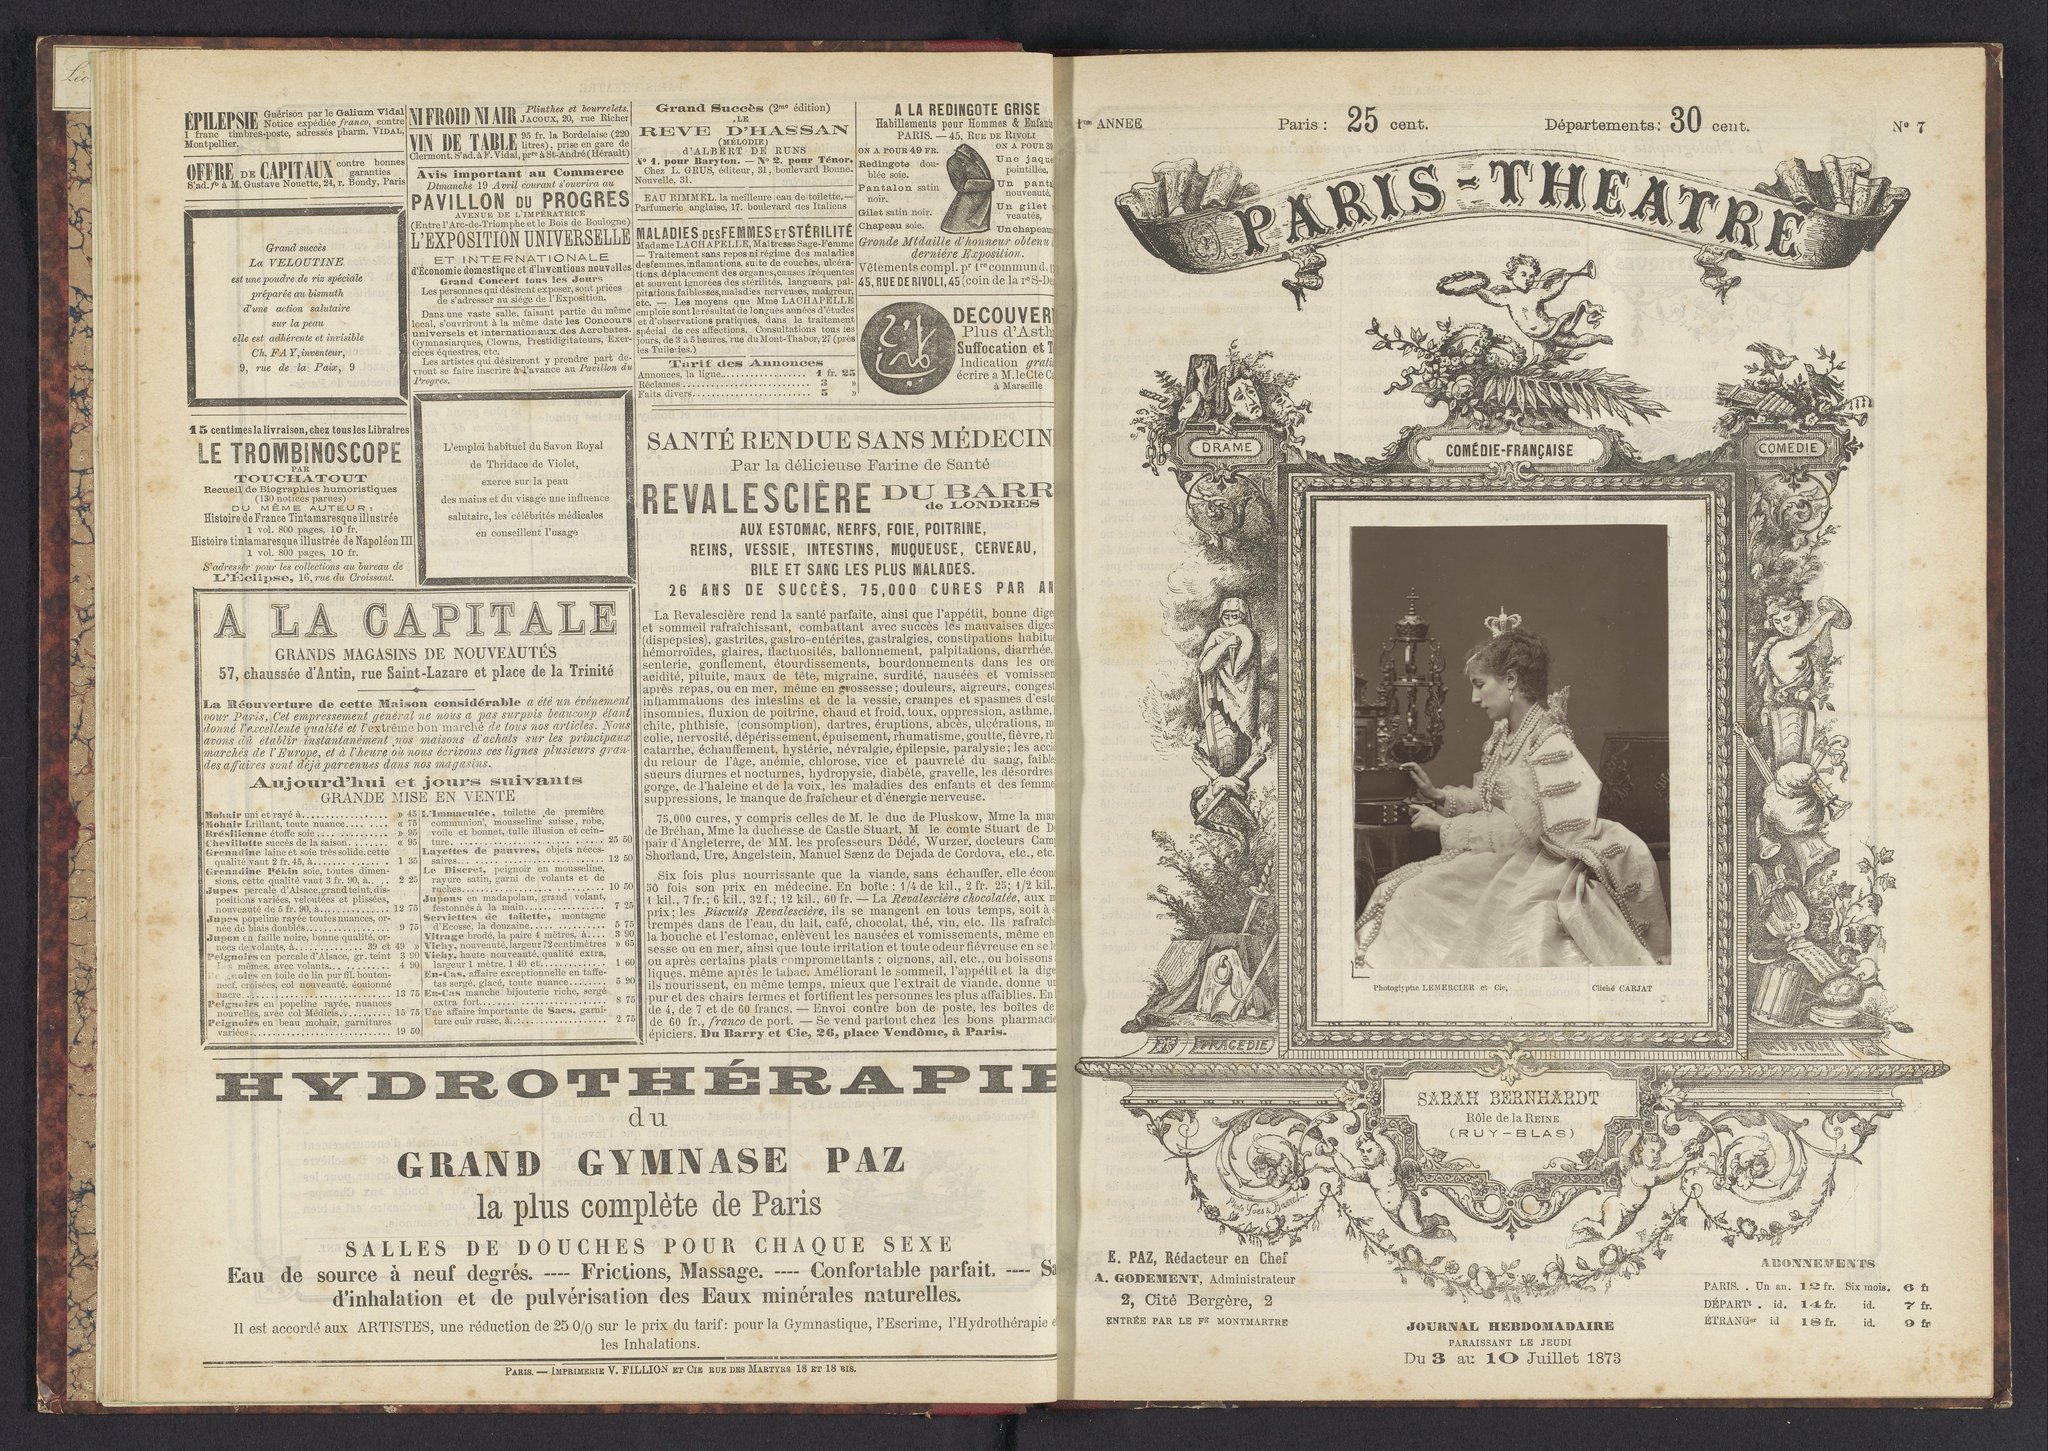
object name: page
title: Sarah Bernhardt Rôle de la Reine (Ruy Blas)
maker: étienne carjat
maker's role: draughtsman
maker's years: 1828-1906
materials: paper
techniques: woodburytype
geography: france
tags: paris, sculptor, sarah bernhardt, crown (symbol of sovereignty), portrait of actor, actress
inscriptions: number: ‘No 7’, inscription: ‘Journal hebdomadaire paraissant le jeudi du 3 au 10 Juillet 1873’